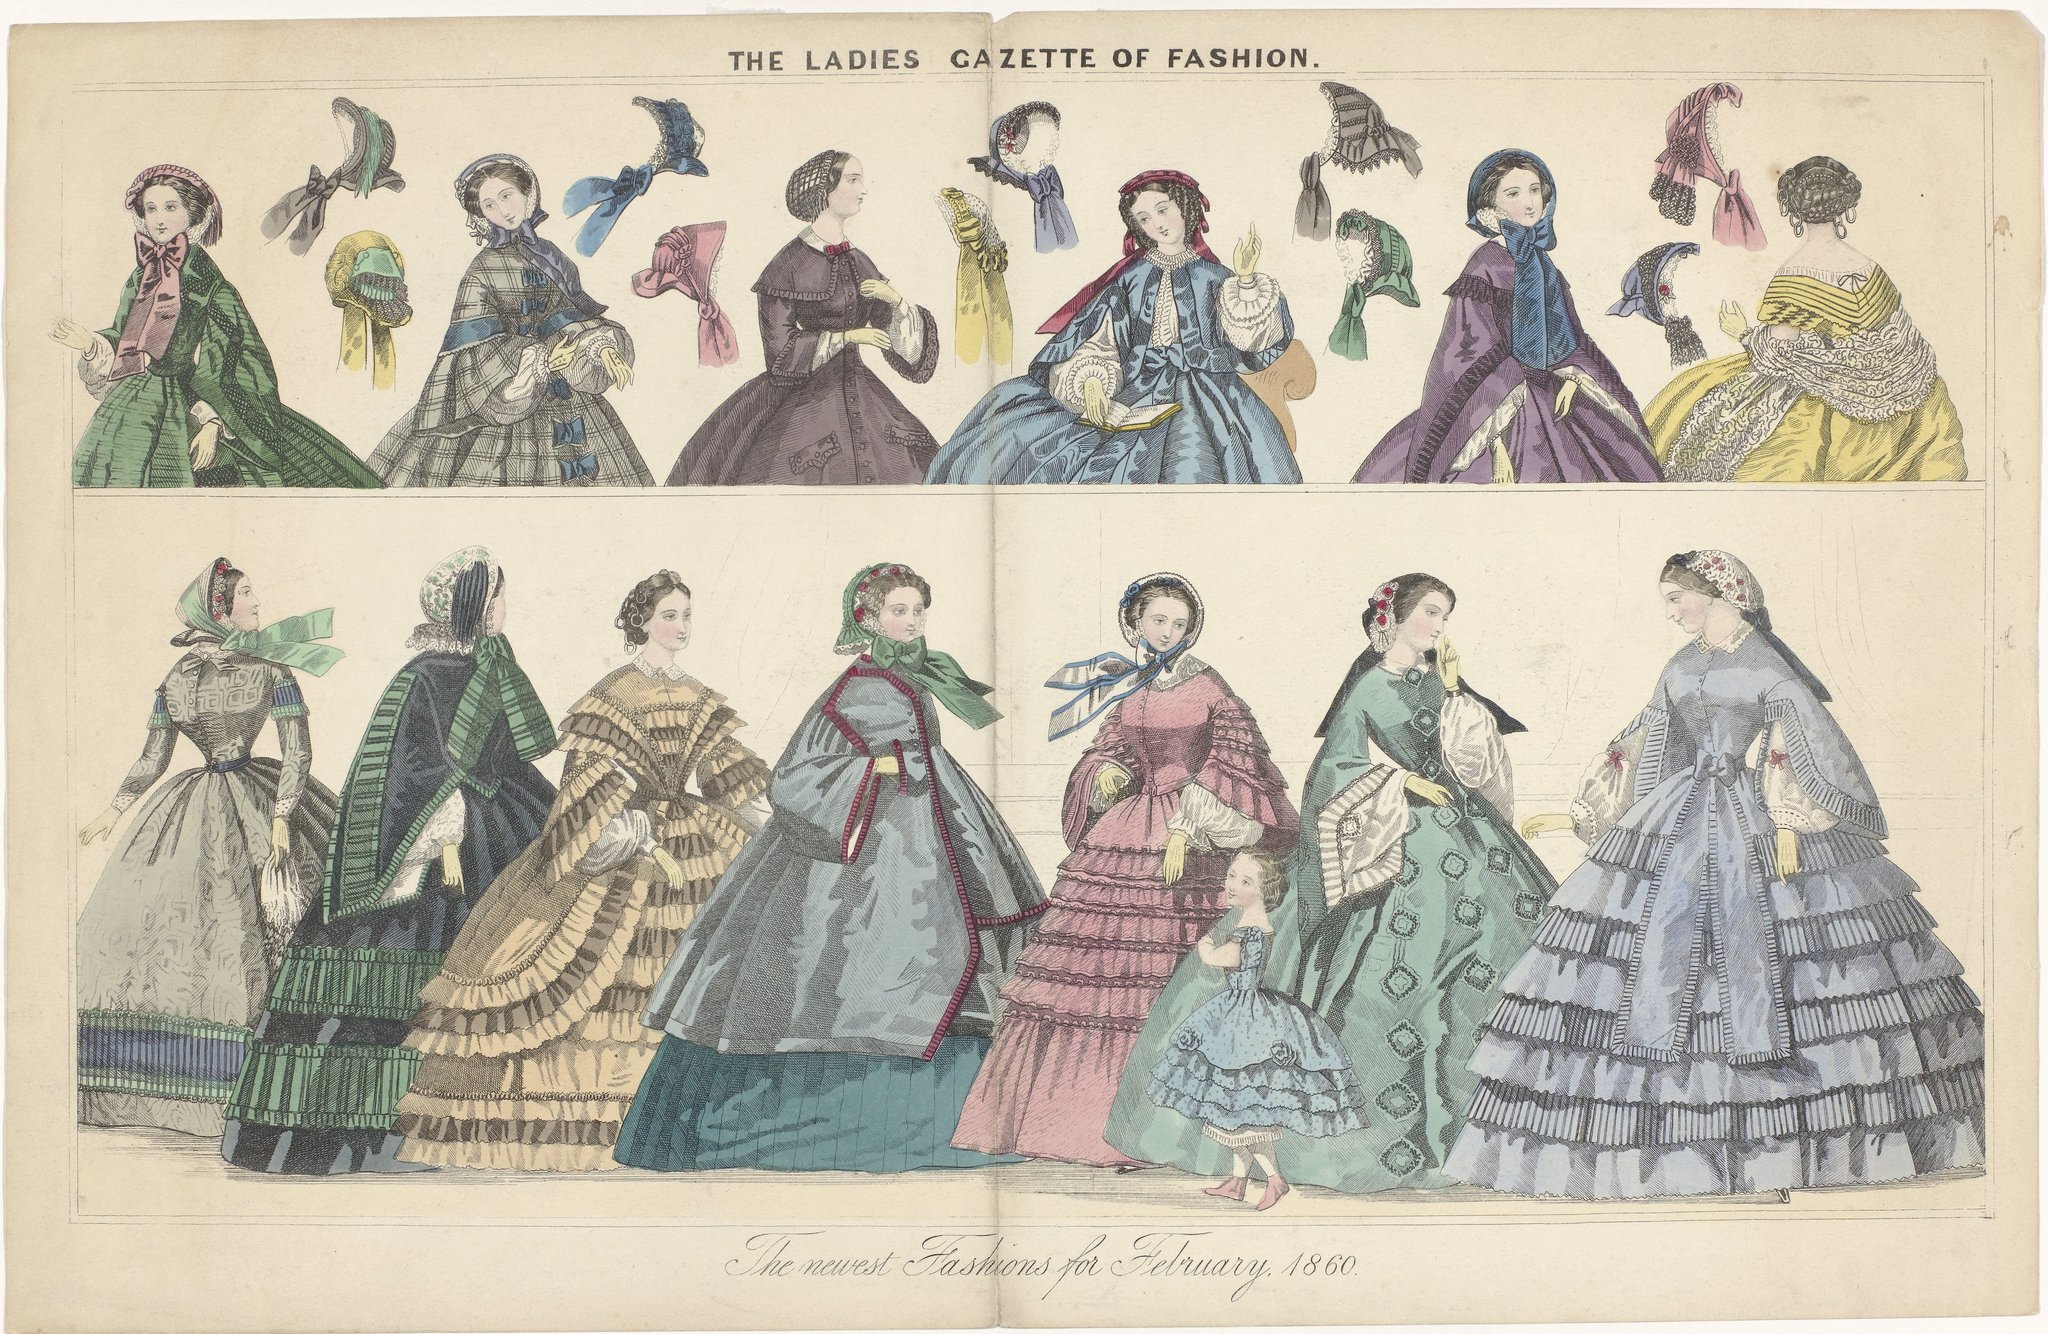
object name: fashion print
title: The Ladies Gazette of Fashion, The newest Fashions for February 1860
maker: Anonymous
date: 1860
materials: paper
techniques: engraving, hand coloring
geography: london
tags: coat (+ women's clothes), fashion plates, skirt (+ women's clothes), dress, gown (+ girls' clothes)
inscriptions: title: ‘THE LADIES GAZETTE OF FASHION’, caption: ‘The newest Fashions for February 1860.’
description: De nieuwste modes voor februari 1860. Boven: zes vrouwen ten halven lijve en tien verschillende hoofddeksels. Onder: zeven vrouwen en een meisje in verschillende japonnen. Prent uit het Engelse modetijdschrift 'The Ladies Gazette of Fashion' (1842-1894).